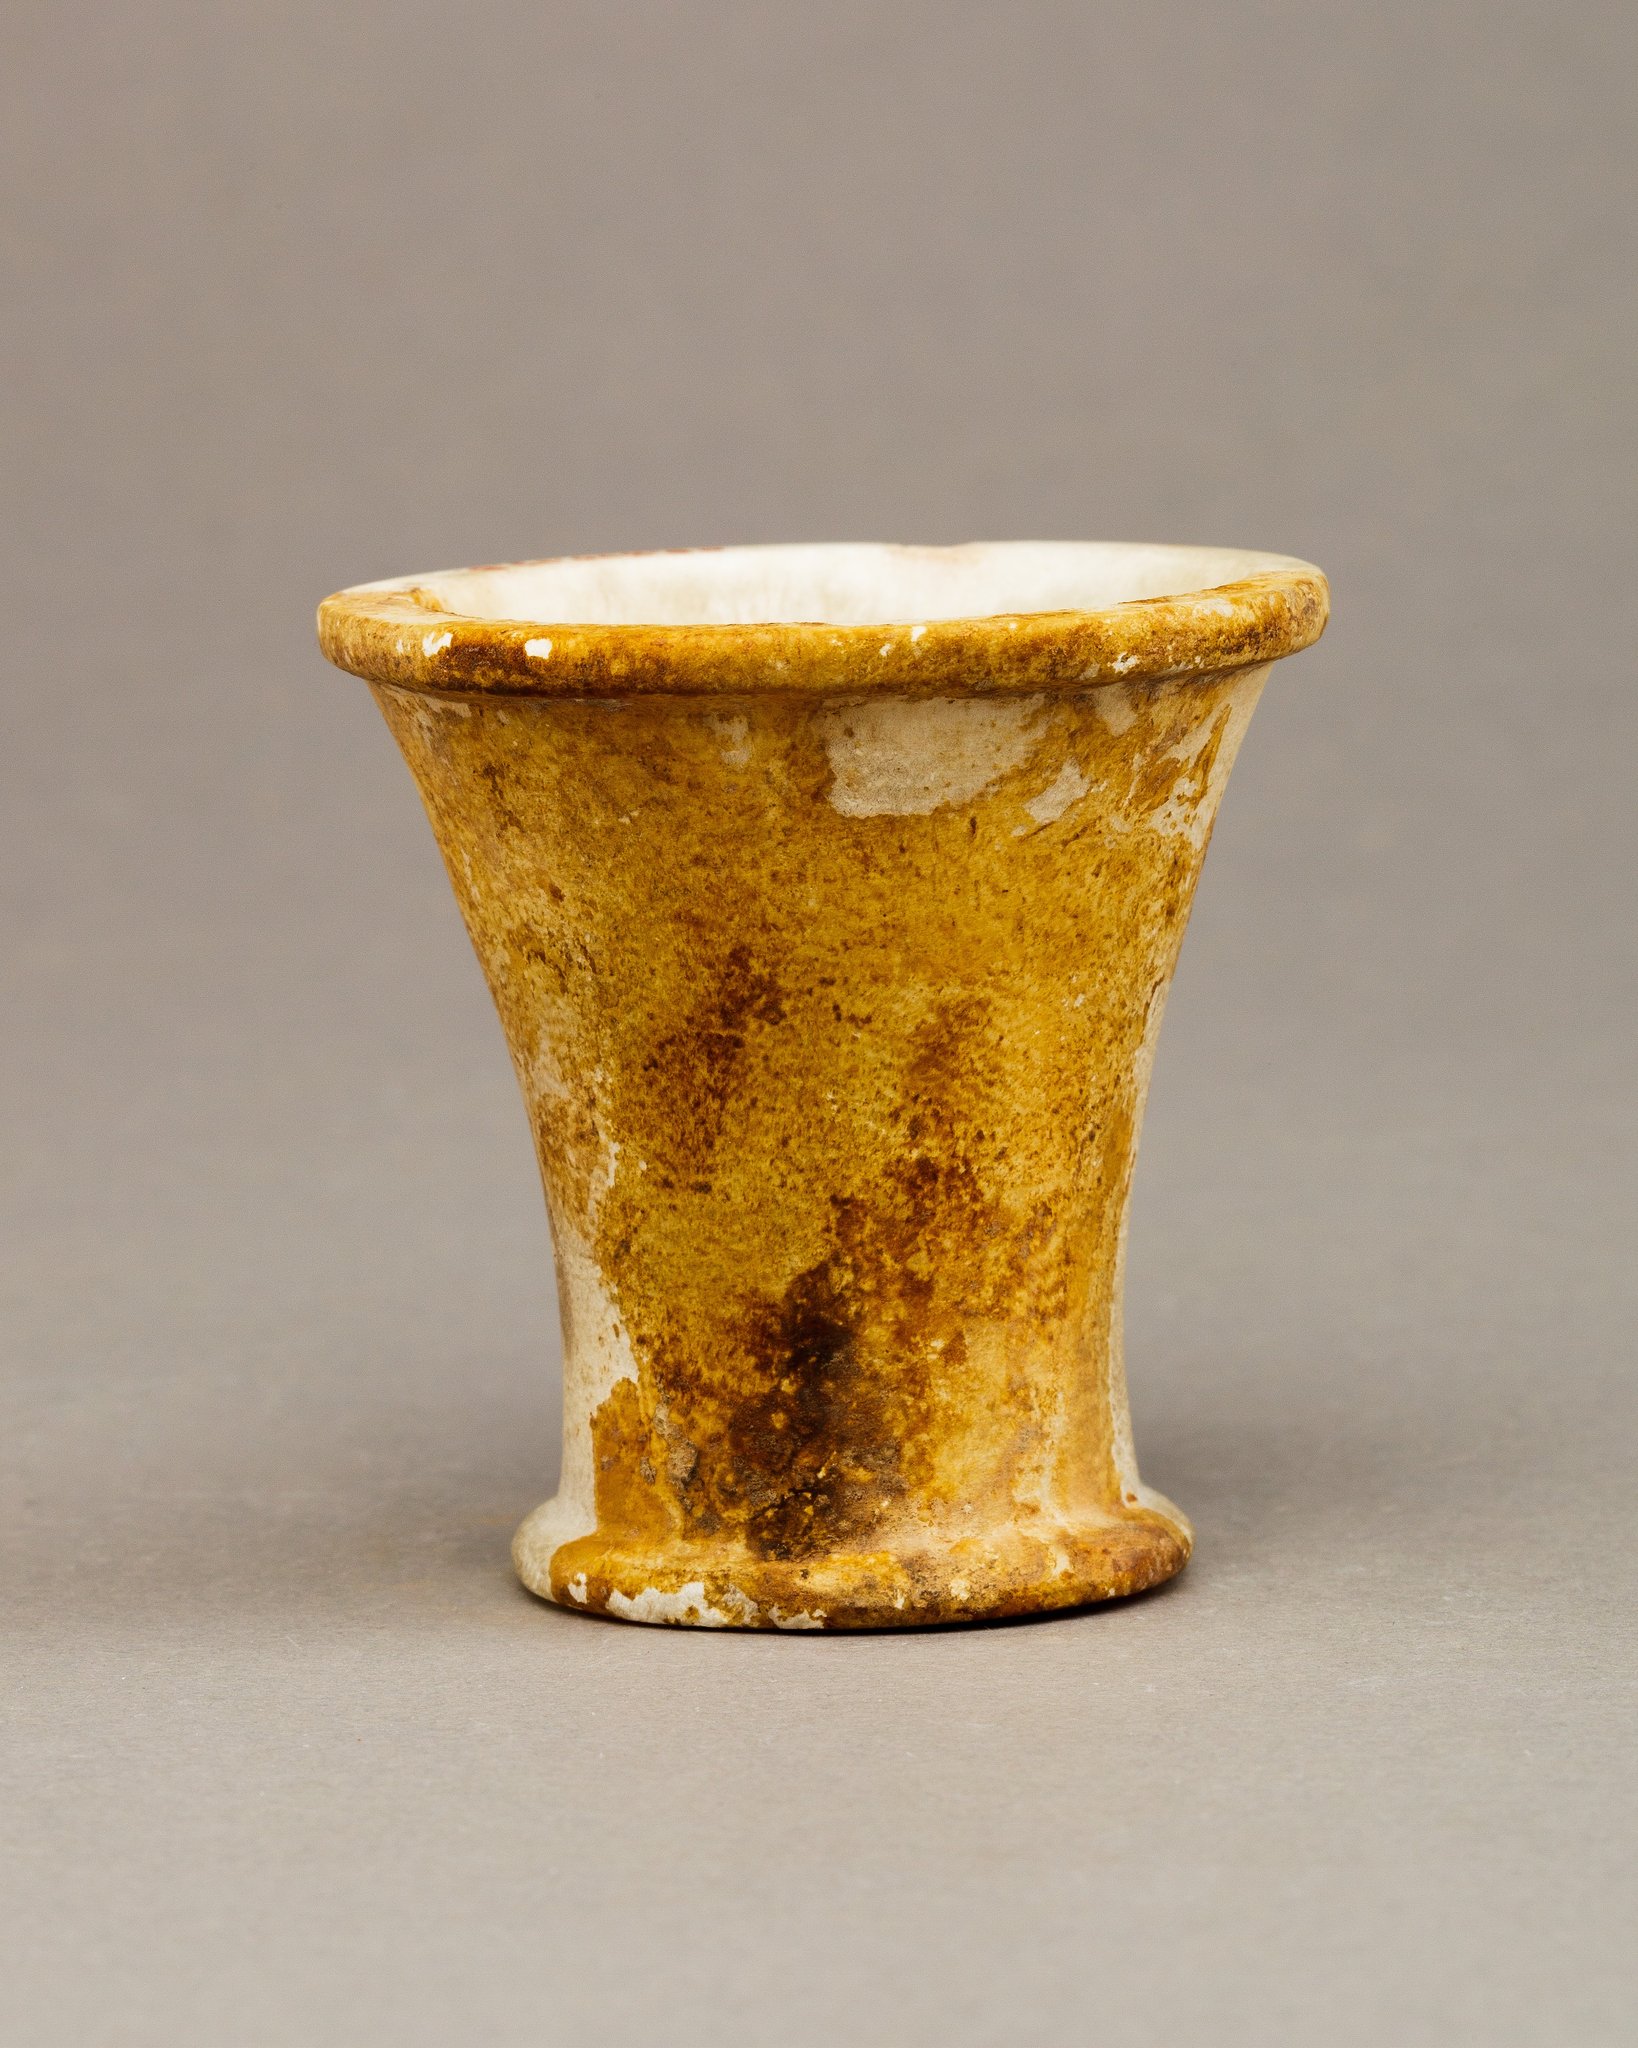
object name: ointment jar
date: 1981-1952 BCE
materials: stone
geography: egypt